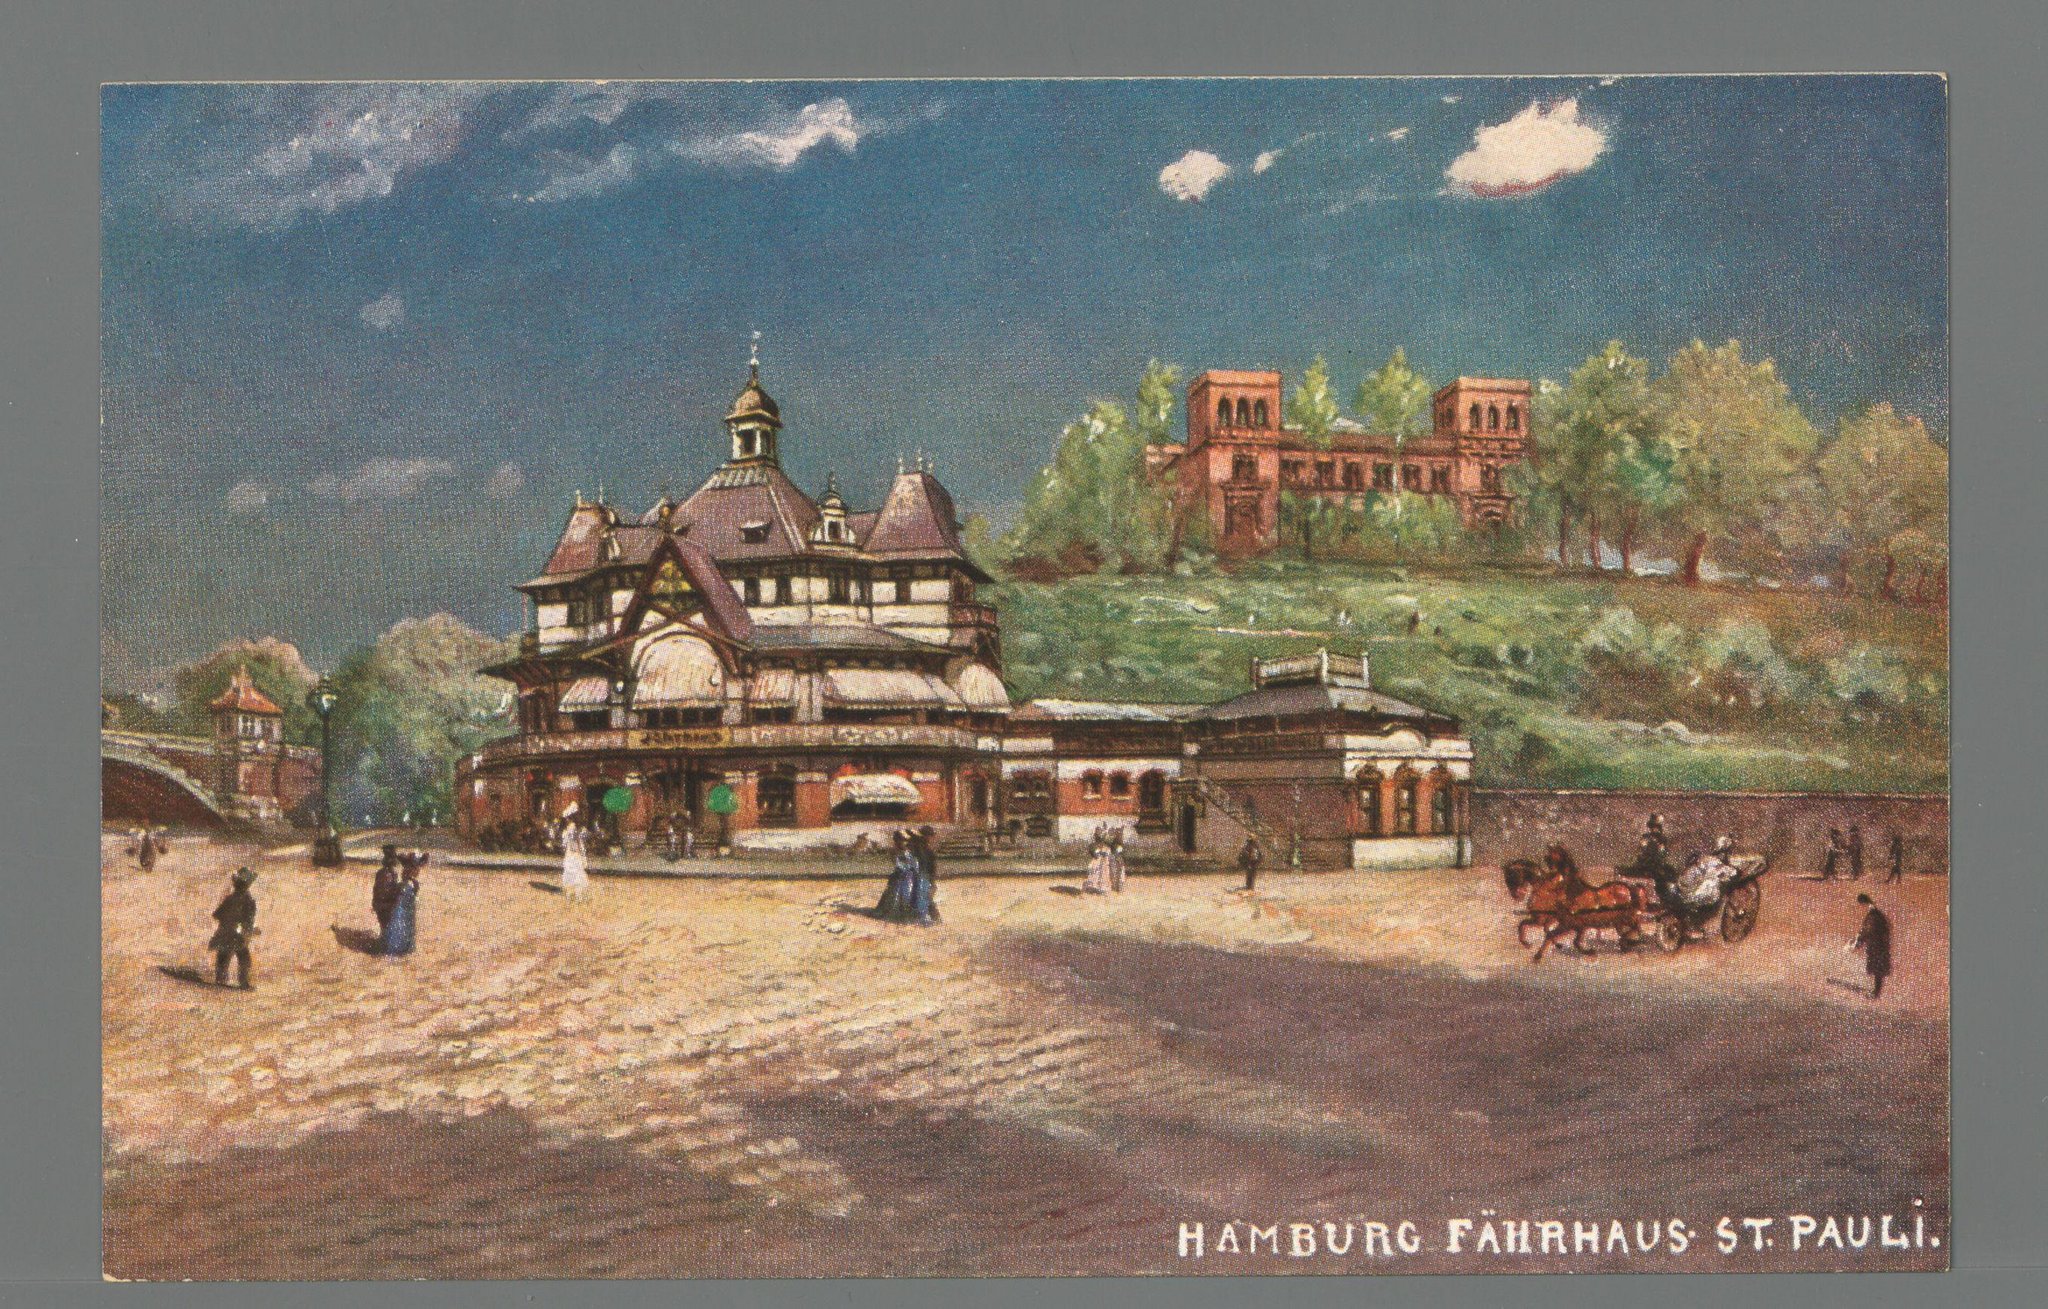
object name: photomechanical print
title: Hamburg. Fährhaus St. Pauli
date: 1905-1930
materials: cardboard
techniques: color autotype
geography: nuremberg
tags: city-view, and landscape with man-made constructions